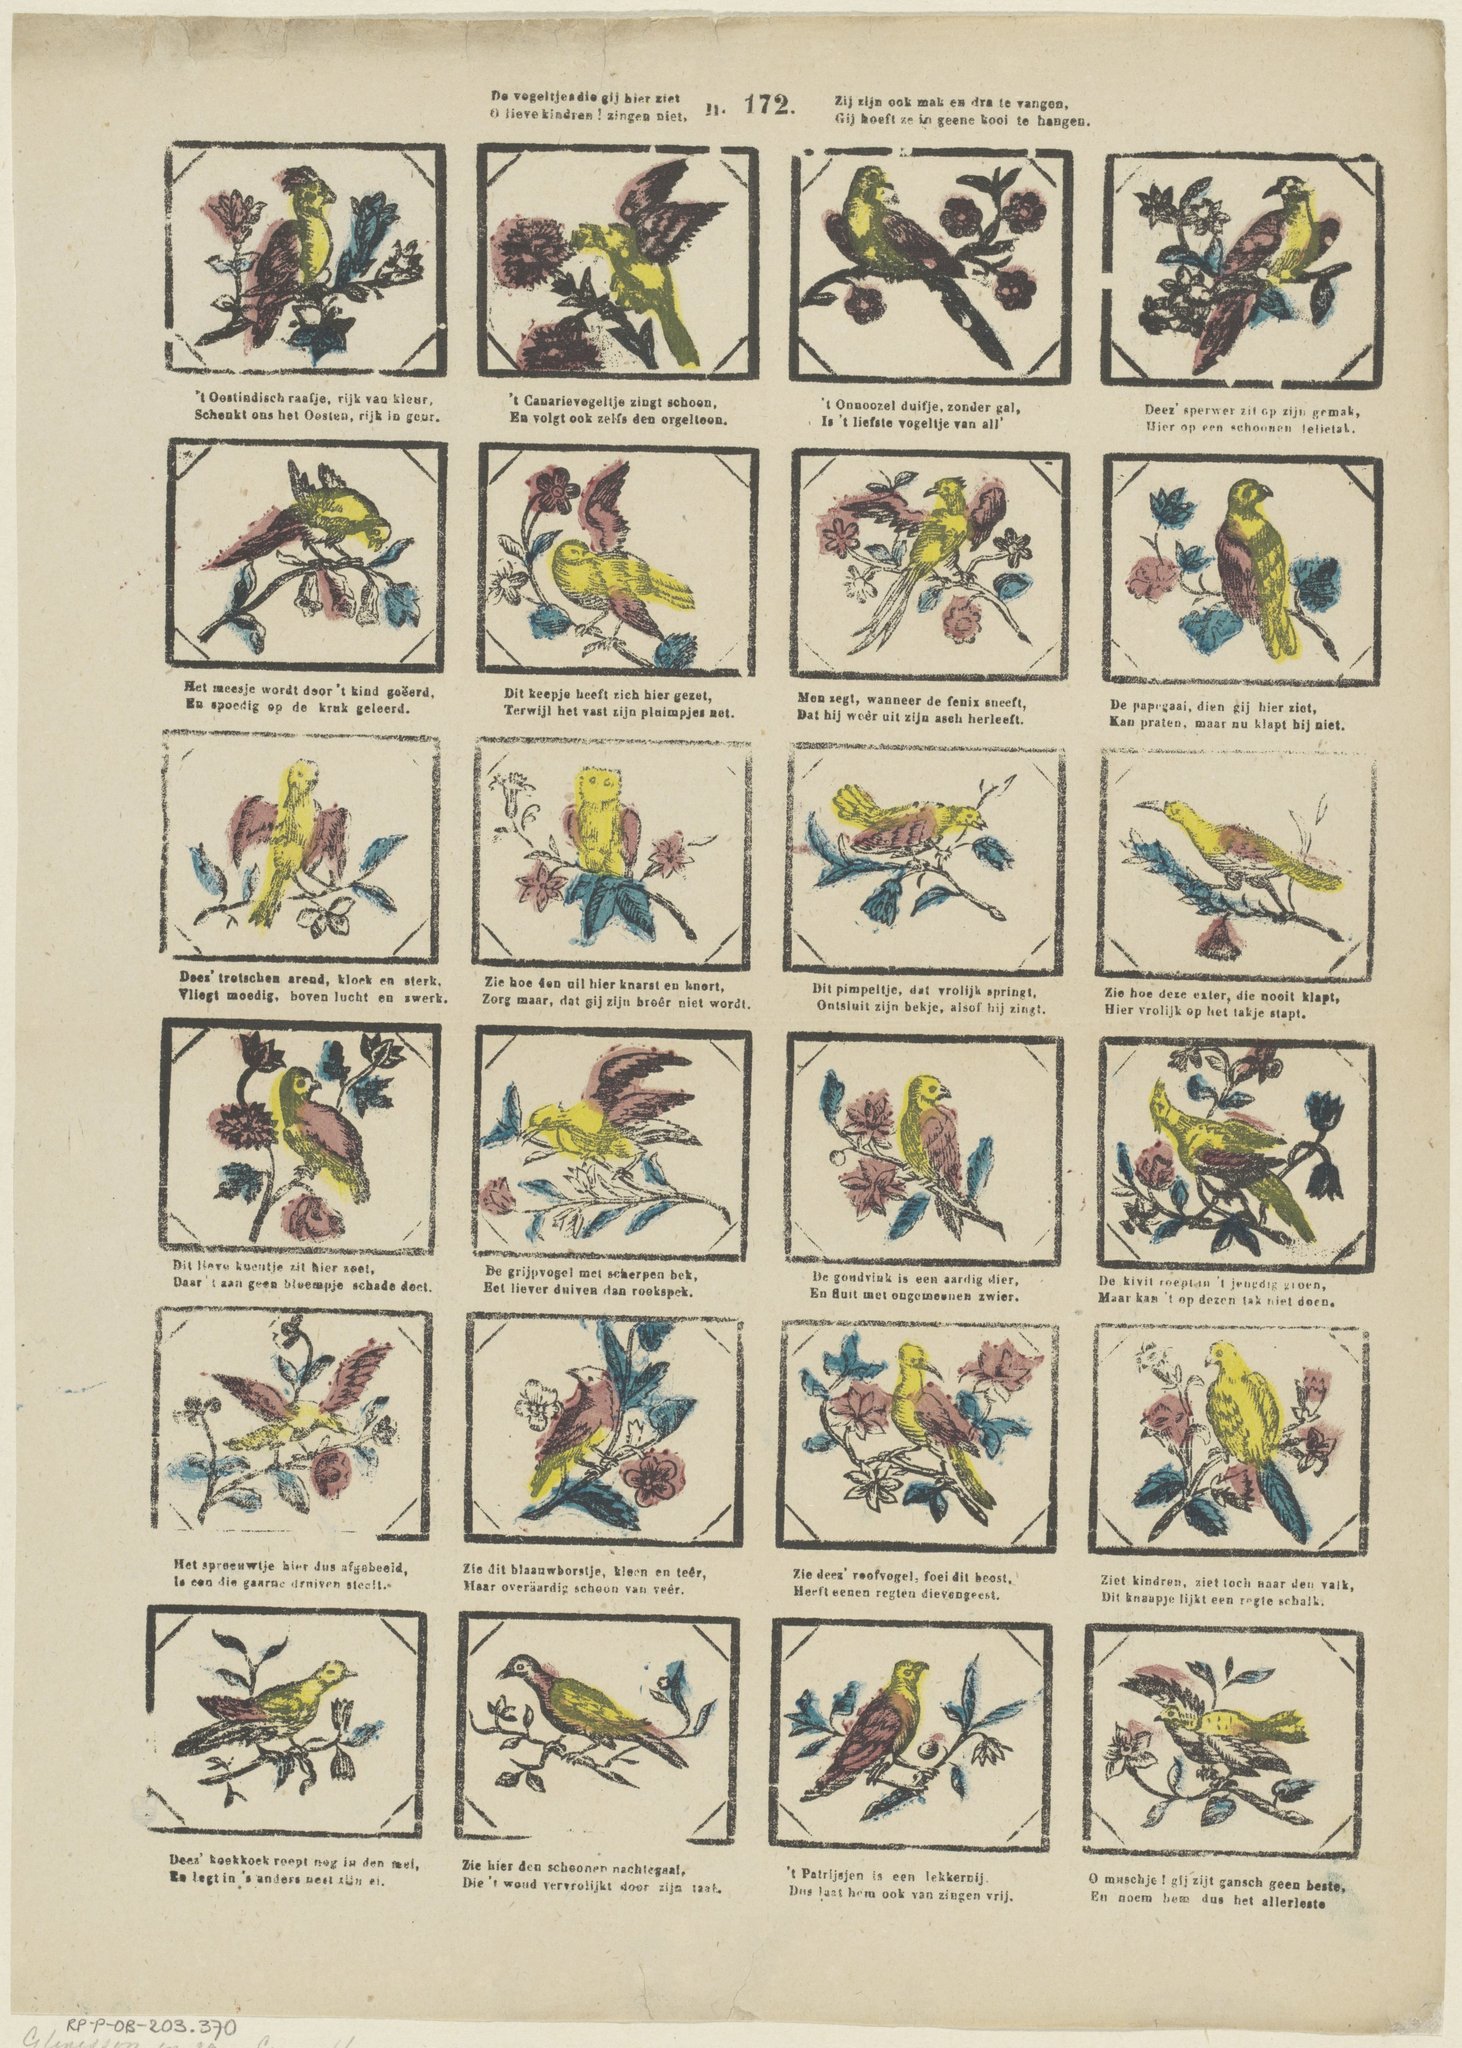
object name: popular print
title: De vogeltjes die gij hier ziet / O lieve kindren! zingen niet, / Zij zijn ook mak en dra te vangen, / Gij hoeft ze in geene kooi te hangen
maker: Anonymous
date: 1856-1900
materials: paper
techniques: colour, letterpress printing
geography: turnhout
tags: birds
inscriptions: collector's mark: Lugt 2760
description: Blad met 24 voorstellingen van vogels op takken. Onder elke afbeelding een tweeregelig vers. Genummerd midden boven: n. 172.